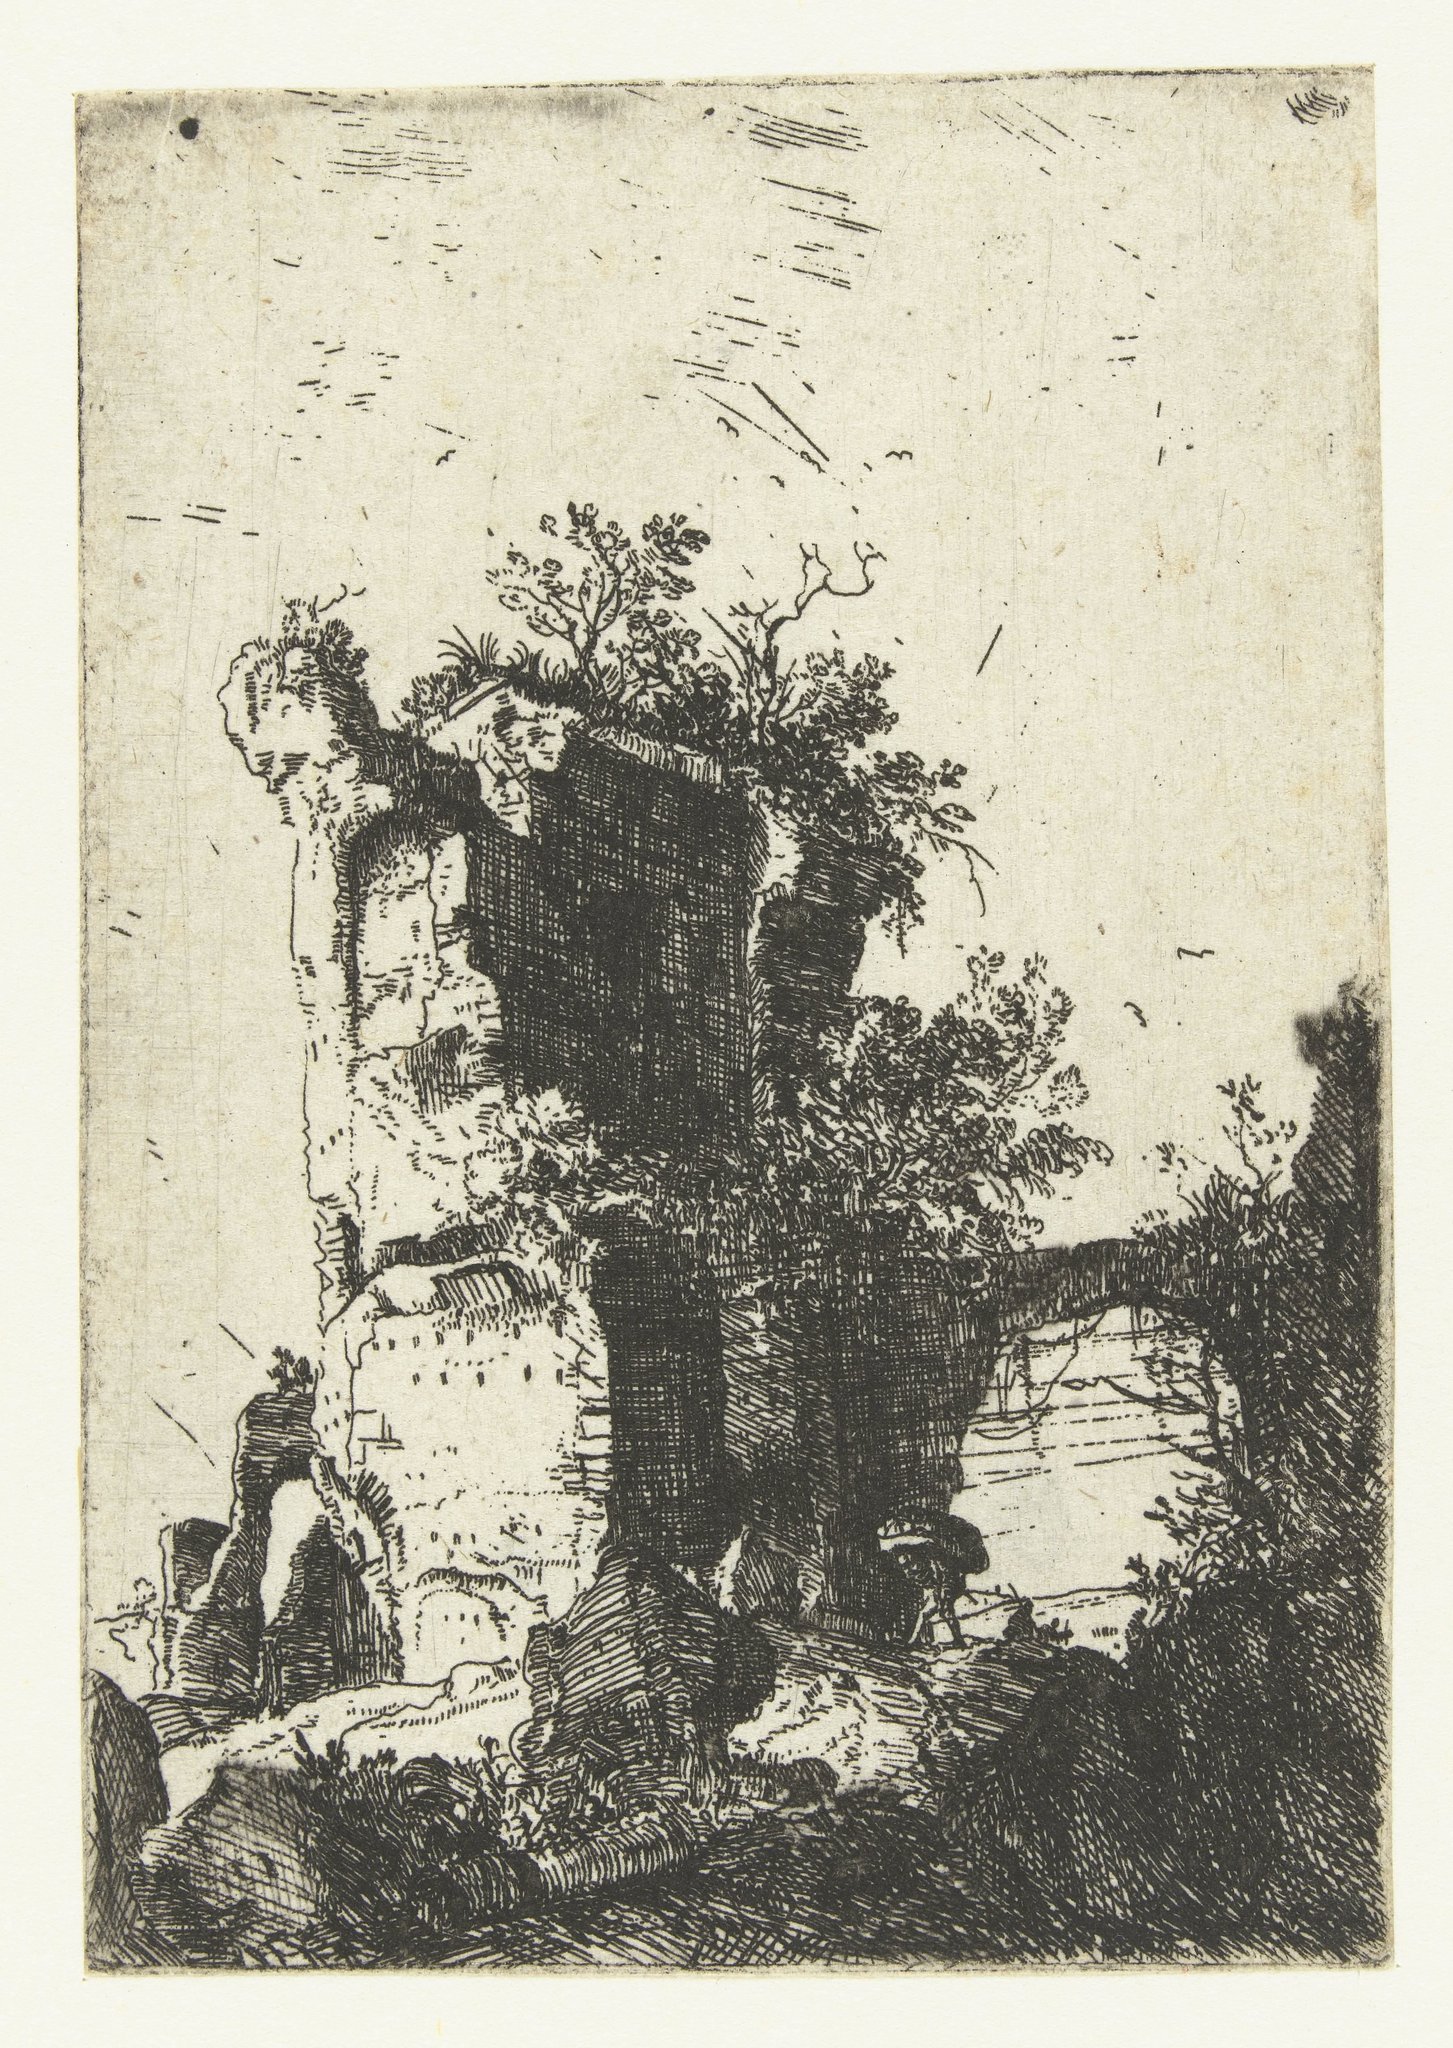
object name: print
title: Verscheijden Vervallen gebouwe Soo binnen als buyten Romen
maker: bartholomeus breenbergh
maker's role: draughtsman, print maker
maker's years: 1599-1657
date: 1639-1640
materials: paper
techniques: etching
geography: netherlands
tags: landscape with ruins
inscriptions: collector's mark: Lugt 240